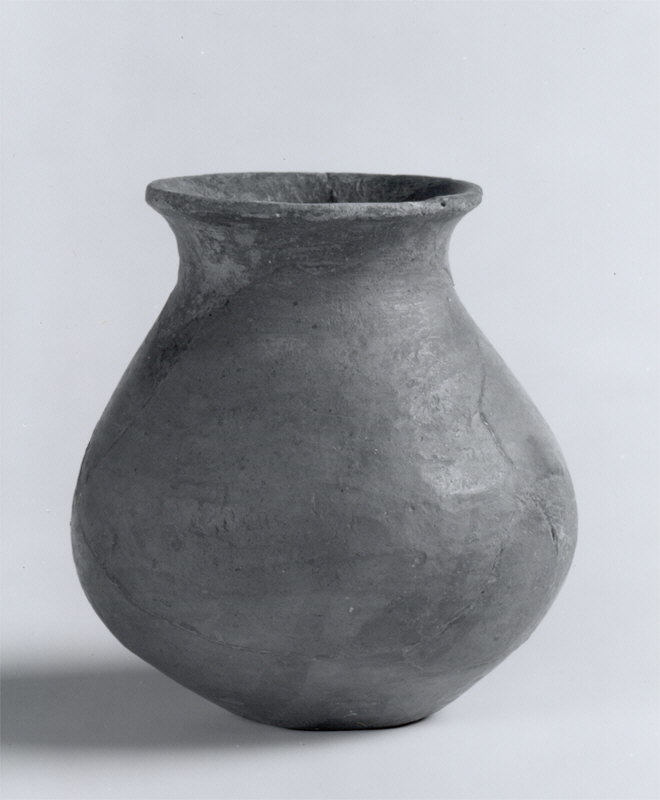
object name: jar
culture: iranian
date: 700-601 BCE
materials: ceramic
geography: iran